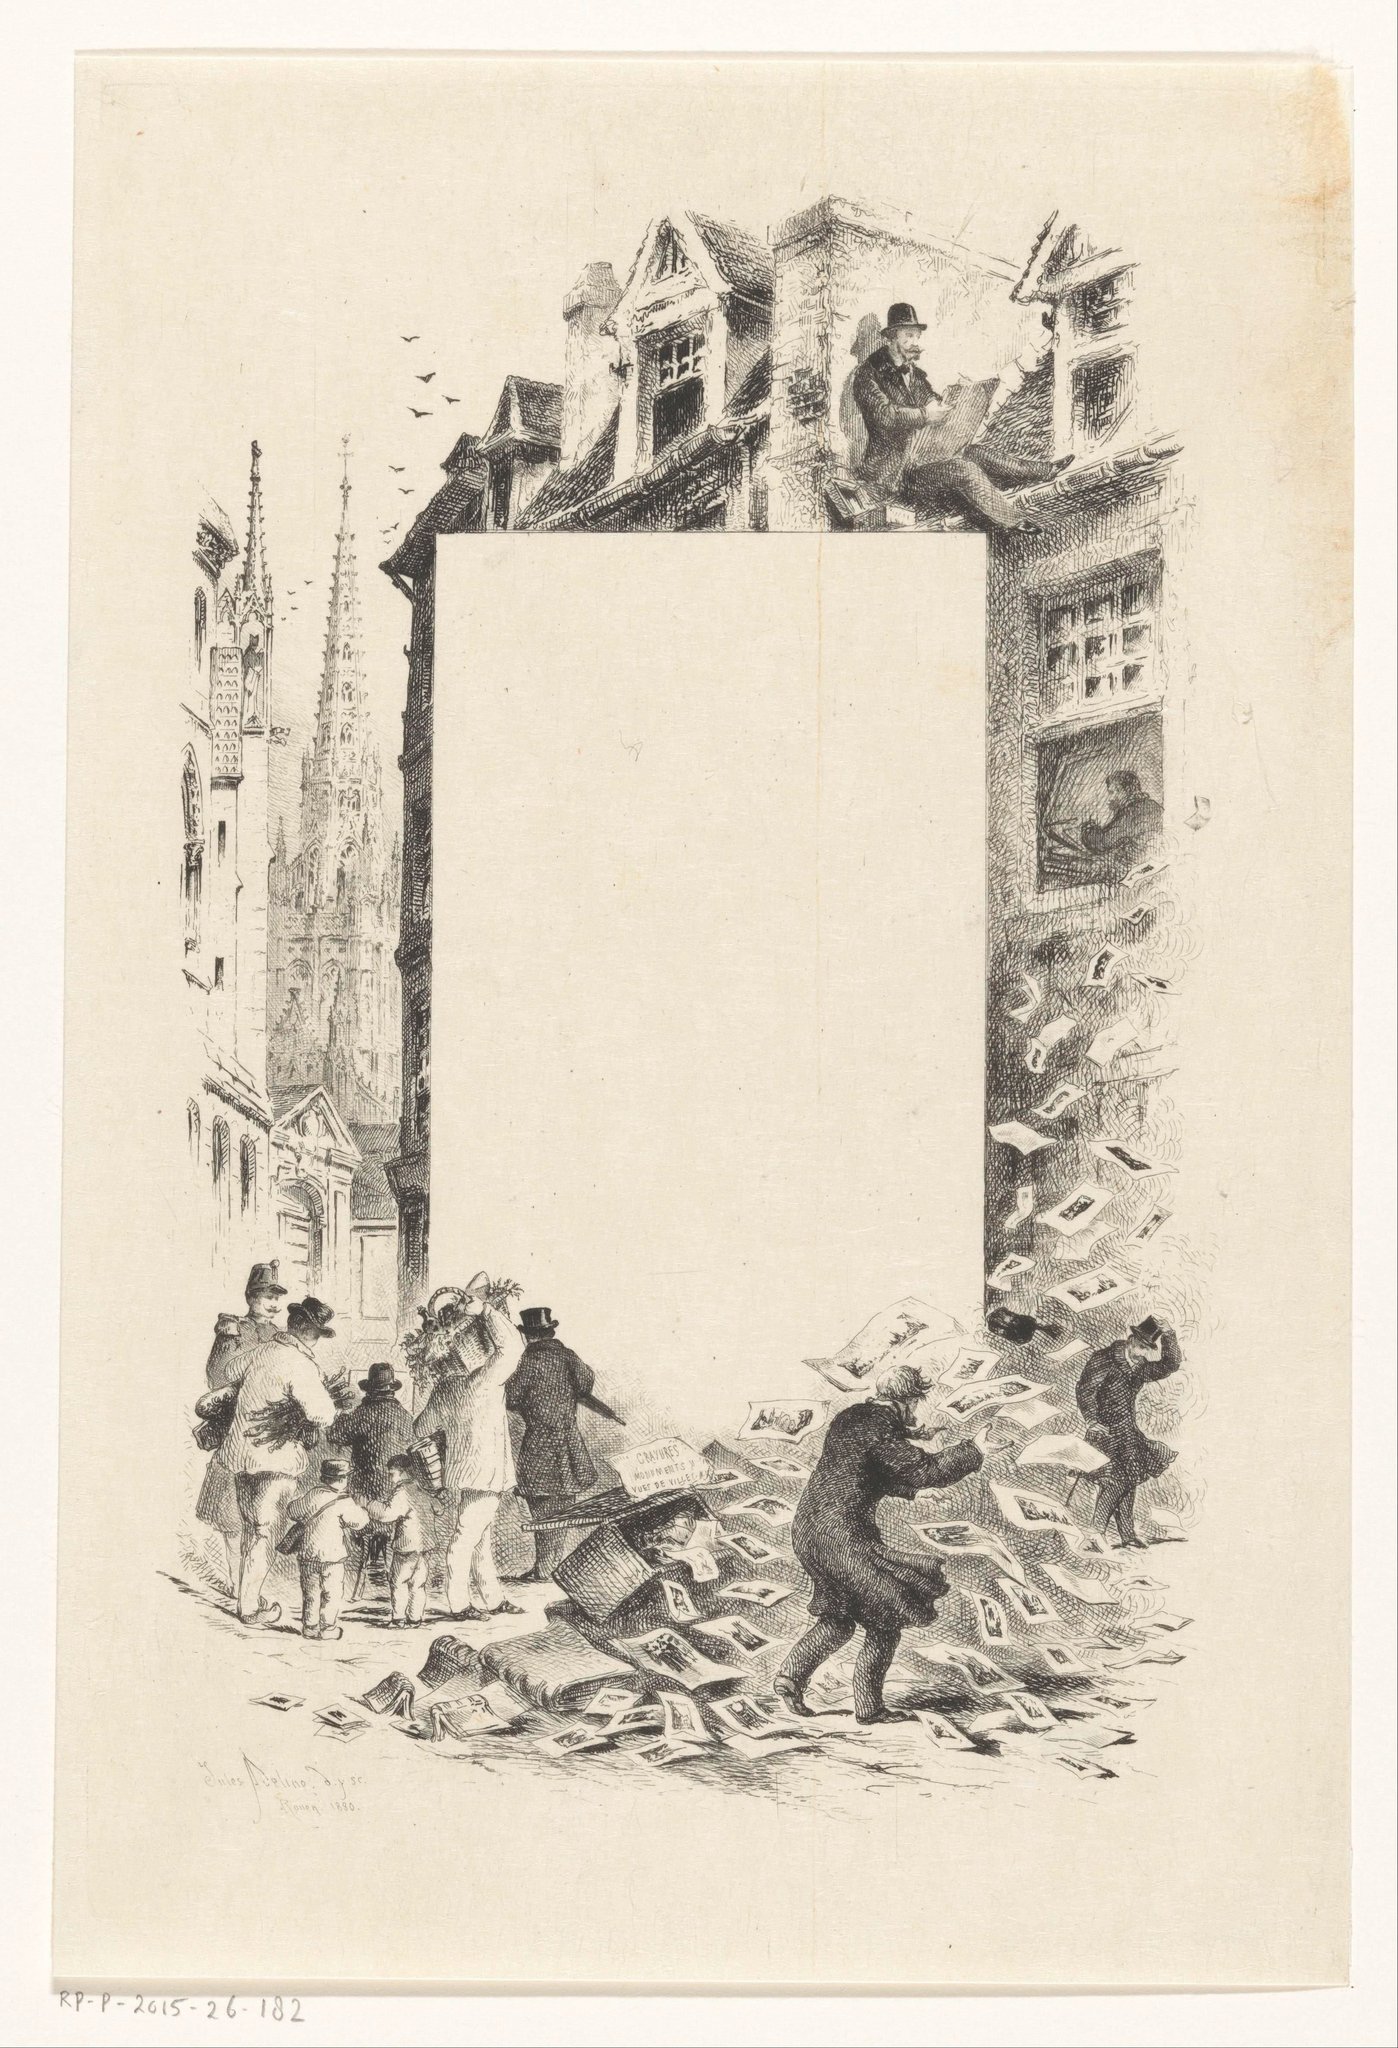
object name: print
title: Straat in Rouen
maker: louis jules adeline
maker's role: print maker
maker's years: 1845-1909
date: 1880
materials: paper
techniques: etching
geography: rouen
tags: print, e.g.: engraving, etching, lithograph, city-view in general; 'veduta' (+ city(-scape) with figures, staffage), working situations of artist - bb - out of doors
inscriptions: collector's mark: Lugt 2228, collector's mark: Lugt 4780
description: Gezicht op een straat in Rouen, de torens van de kathedraal in de achtergrond. Op het dak van een huis zit een man te tekenen en achter een raam is een prentmaker te zien. Op straat heeft zich een groepje mensen verzameld rond een man die aan het tekenen of schilderen is. Op de voorgrond liggen boeken en vanuit een kist waaien prenten de lucht in. Op een blad staat te lezen: Gravures monuments & vues de villes.